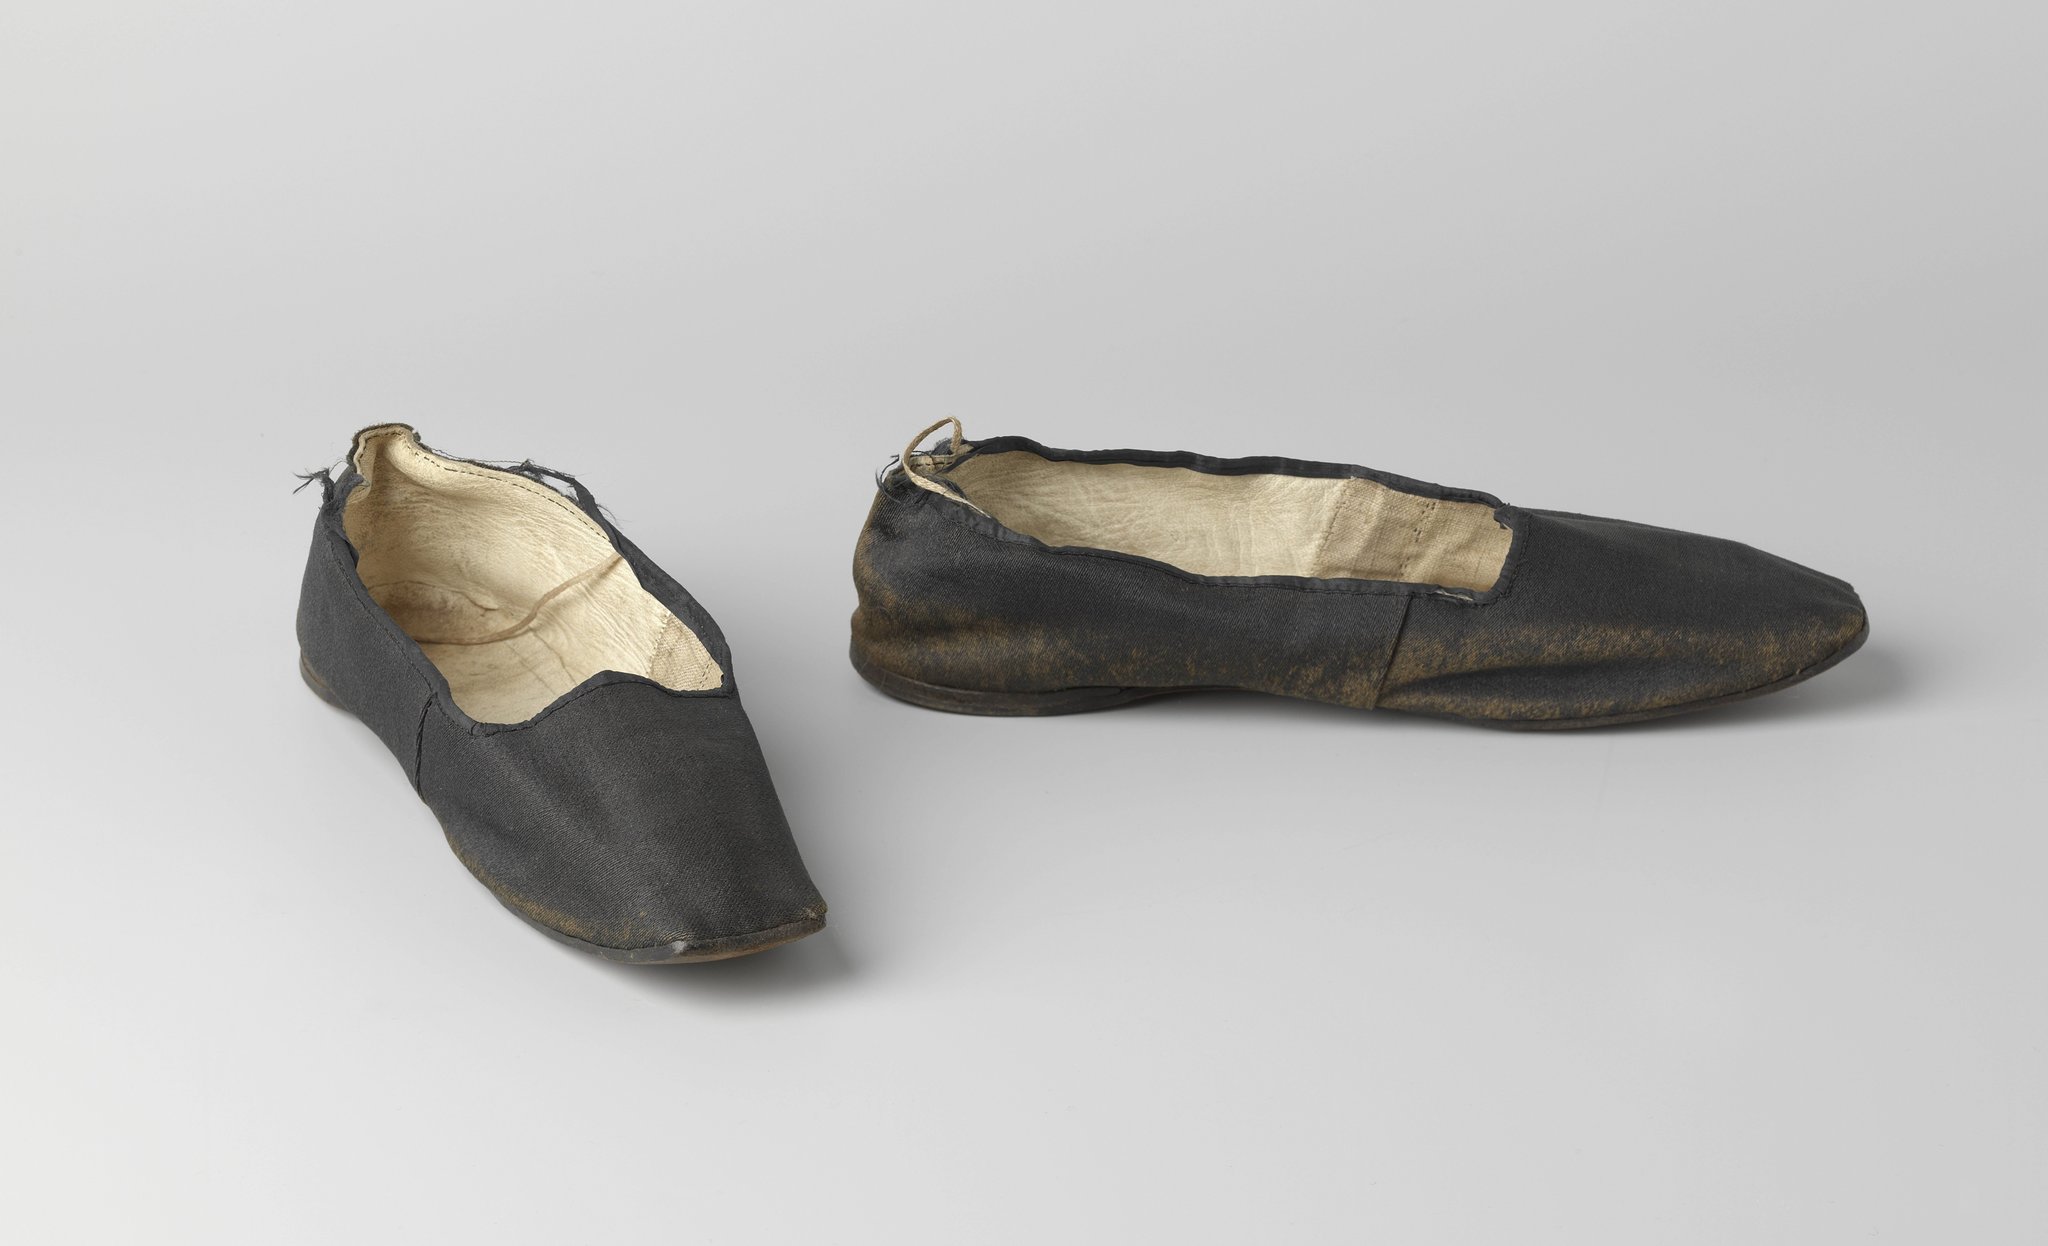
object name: shoe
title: Schoen van zwart katoen met kleine sleehak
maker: Anonymous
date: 1820-1840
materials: cotton, leather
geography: northern netherlands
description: Paar damesschoenen, van zwart katoen. Geen links of rechtse vorm. Ingebouwde hak van één laag leer. Spits toelopende voorvoet. Vierkante neus. Bandsluiting in een zijden omboordsel.